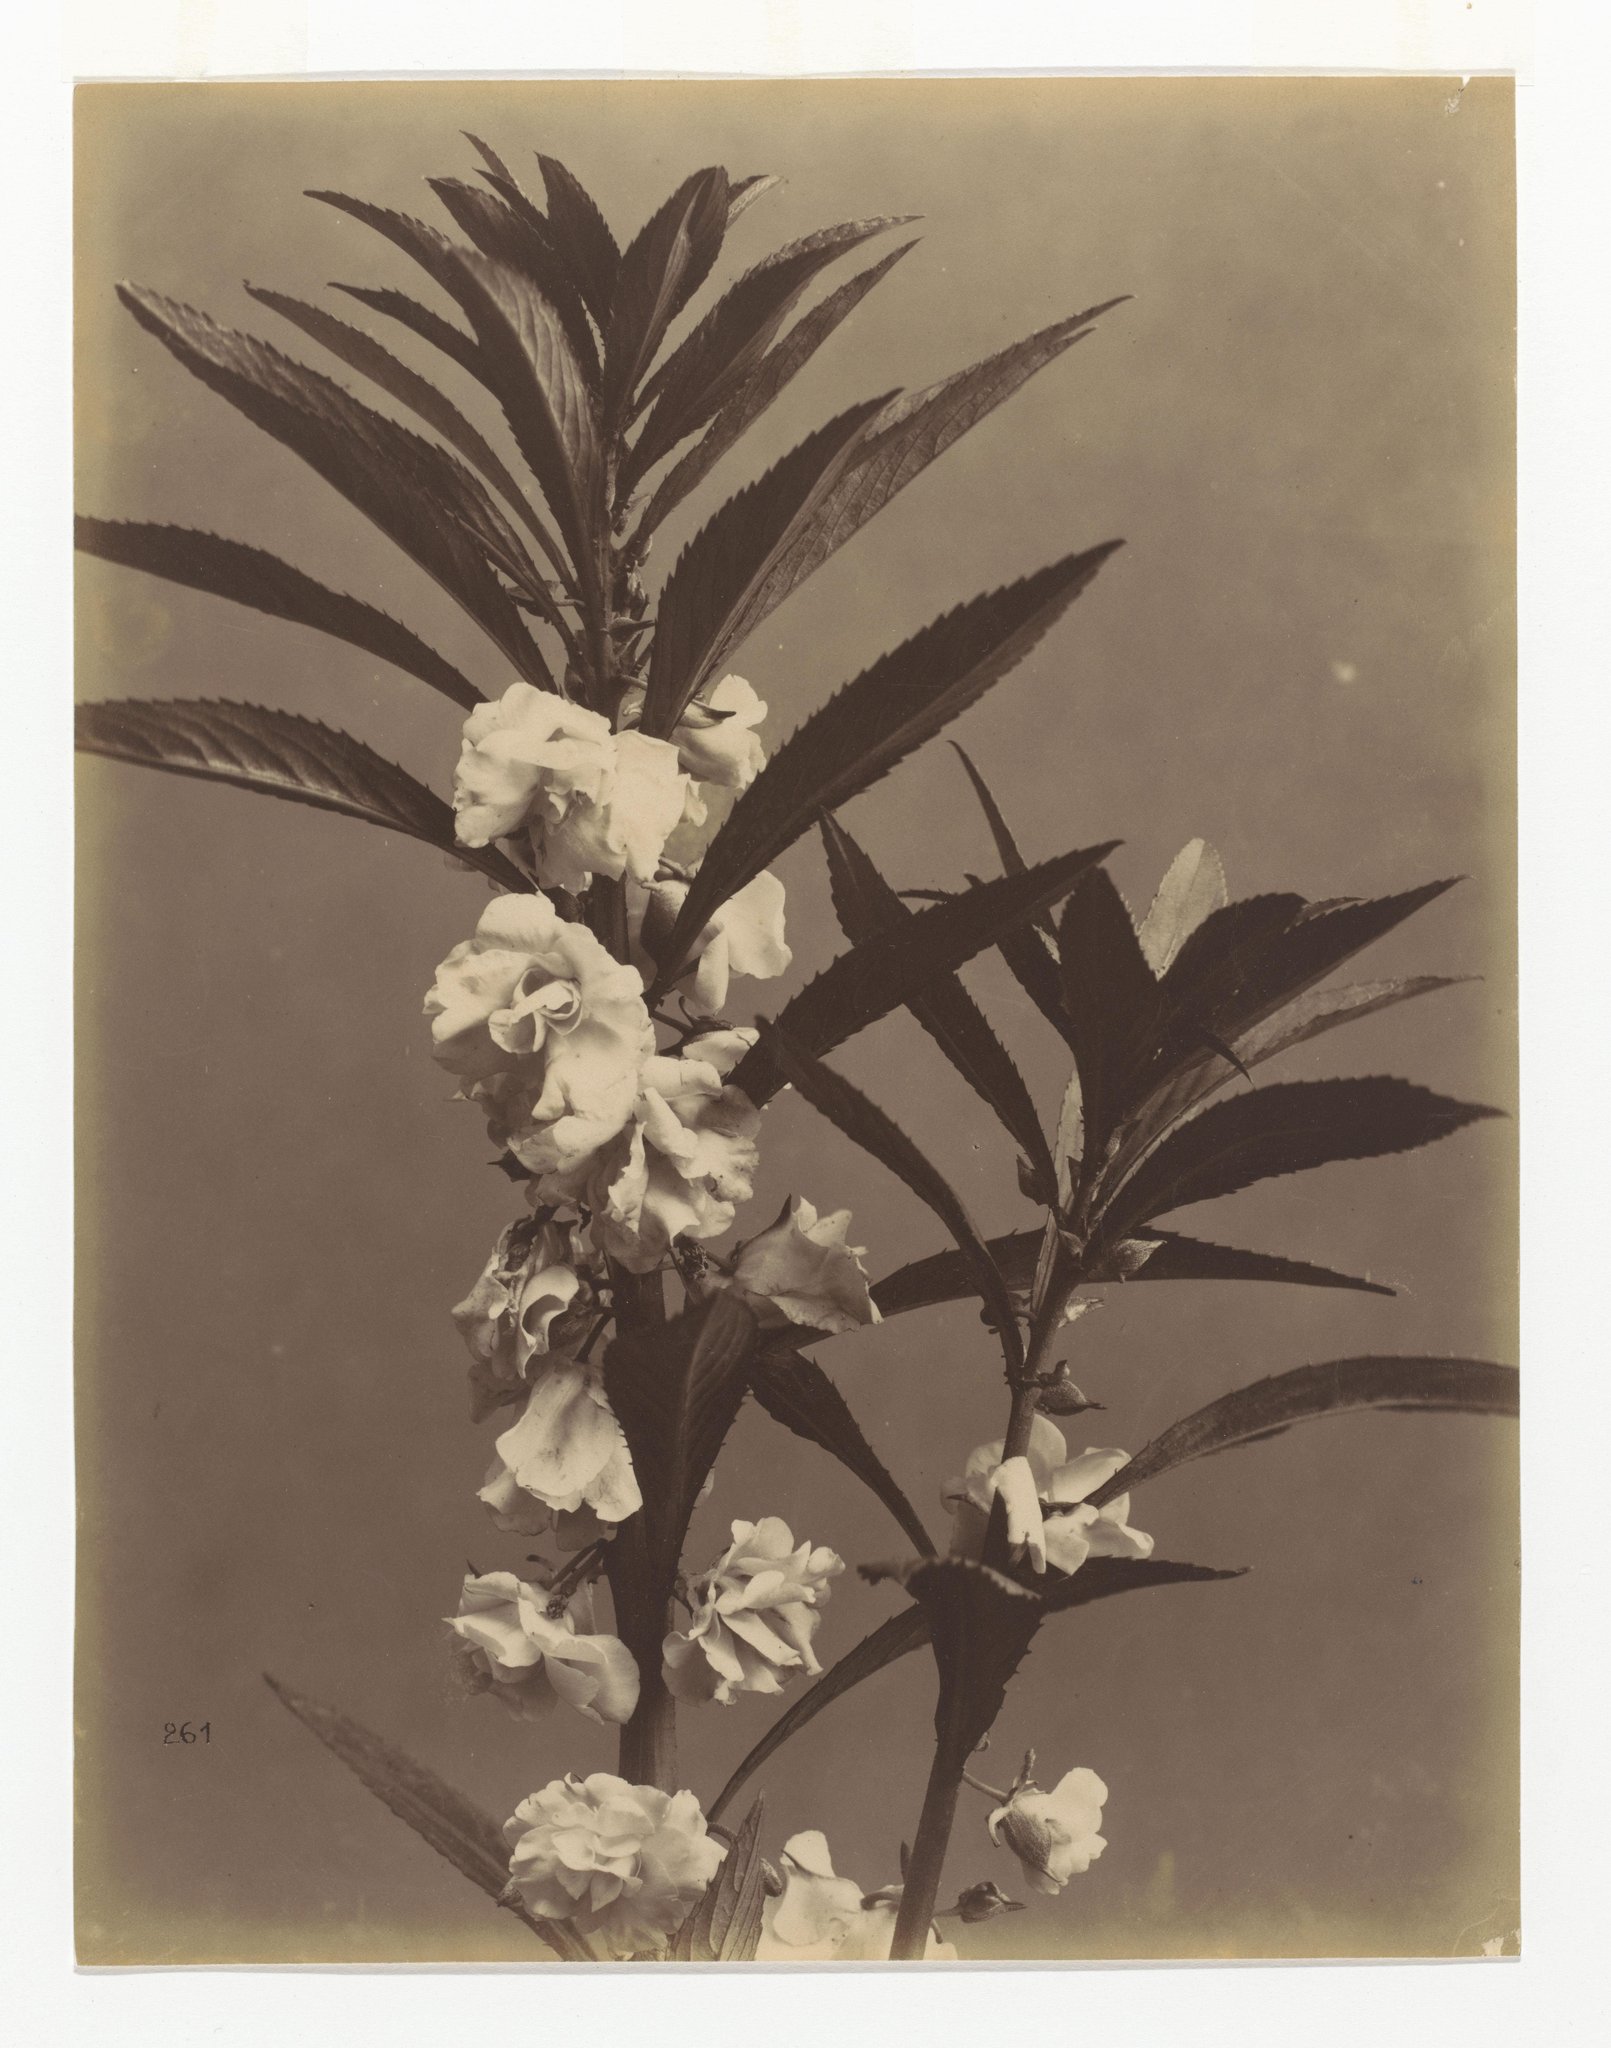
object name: photograph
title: Bloemstilleven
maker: charles aubry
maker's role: fotograaf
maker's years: 1811-1877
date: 1864-1872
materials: paper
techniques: albumen print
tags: flowers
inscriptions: number: ‘261’